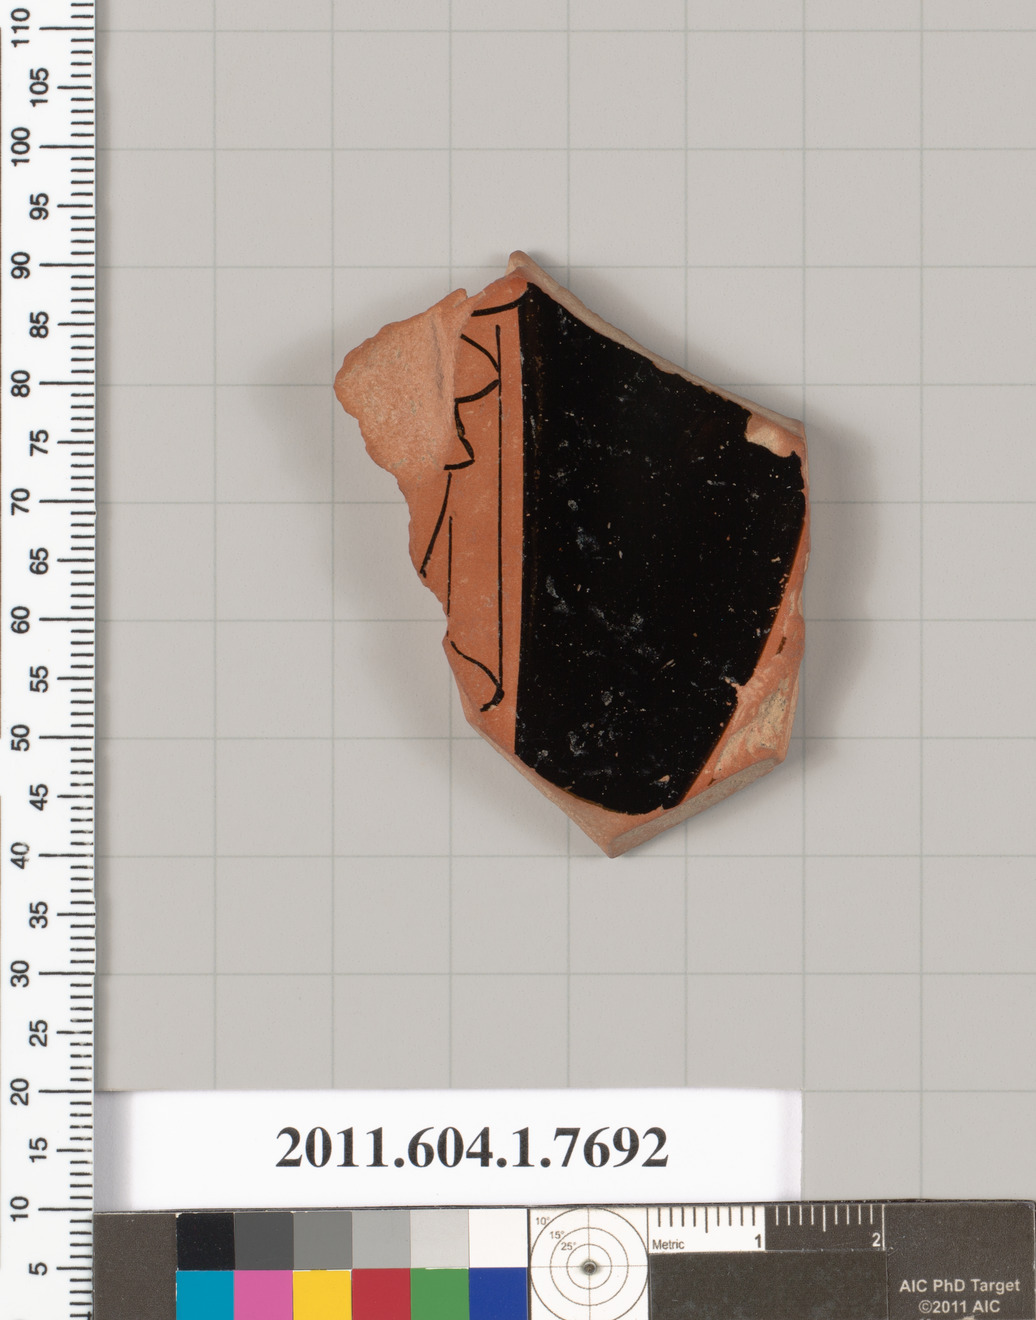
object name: kylix fragment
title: Terracotta fragment of a kylix (drinking cup)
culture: greek, attic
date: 460-450 BCE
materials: terracotta